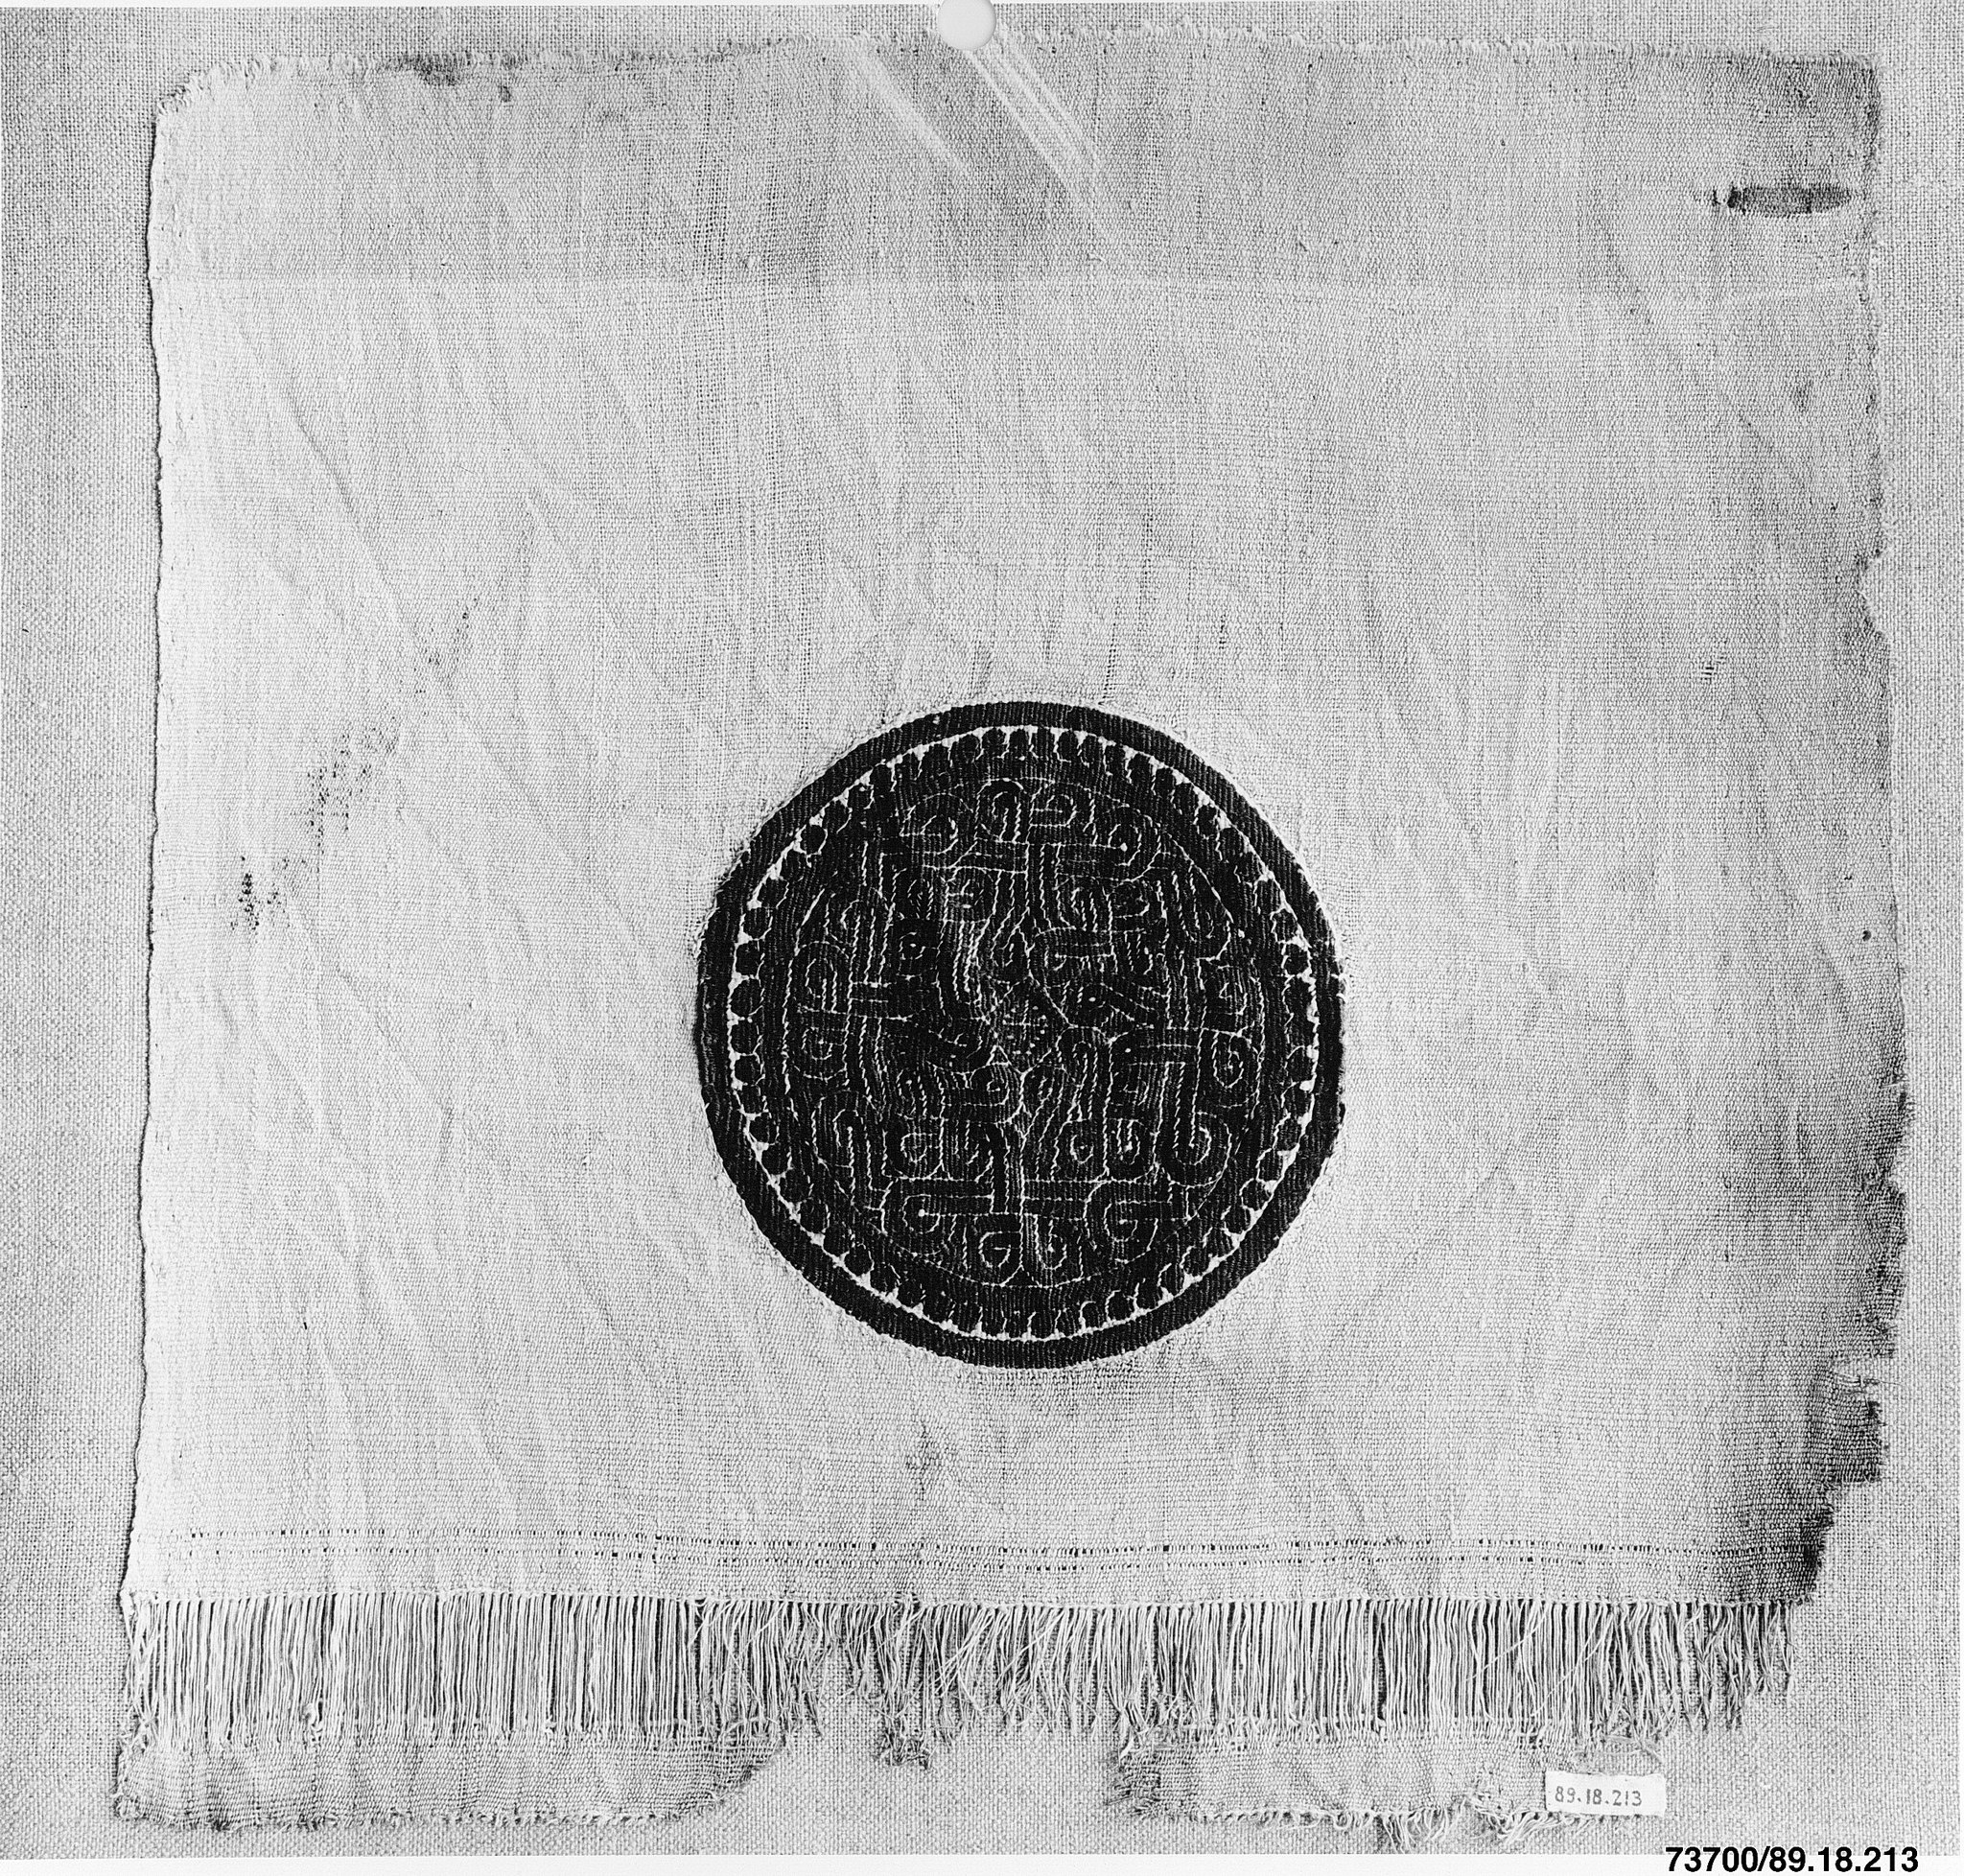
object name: textile fragment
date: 201-400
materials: linen, wool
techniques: weave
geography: egypt